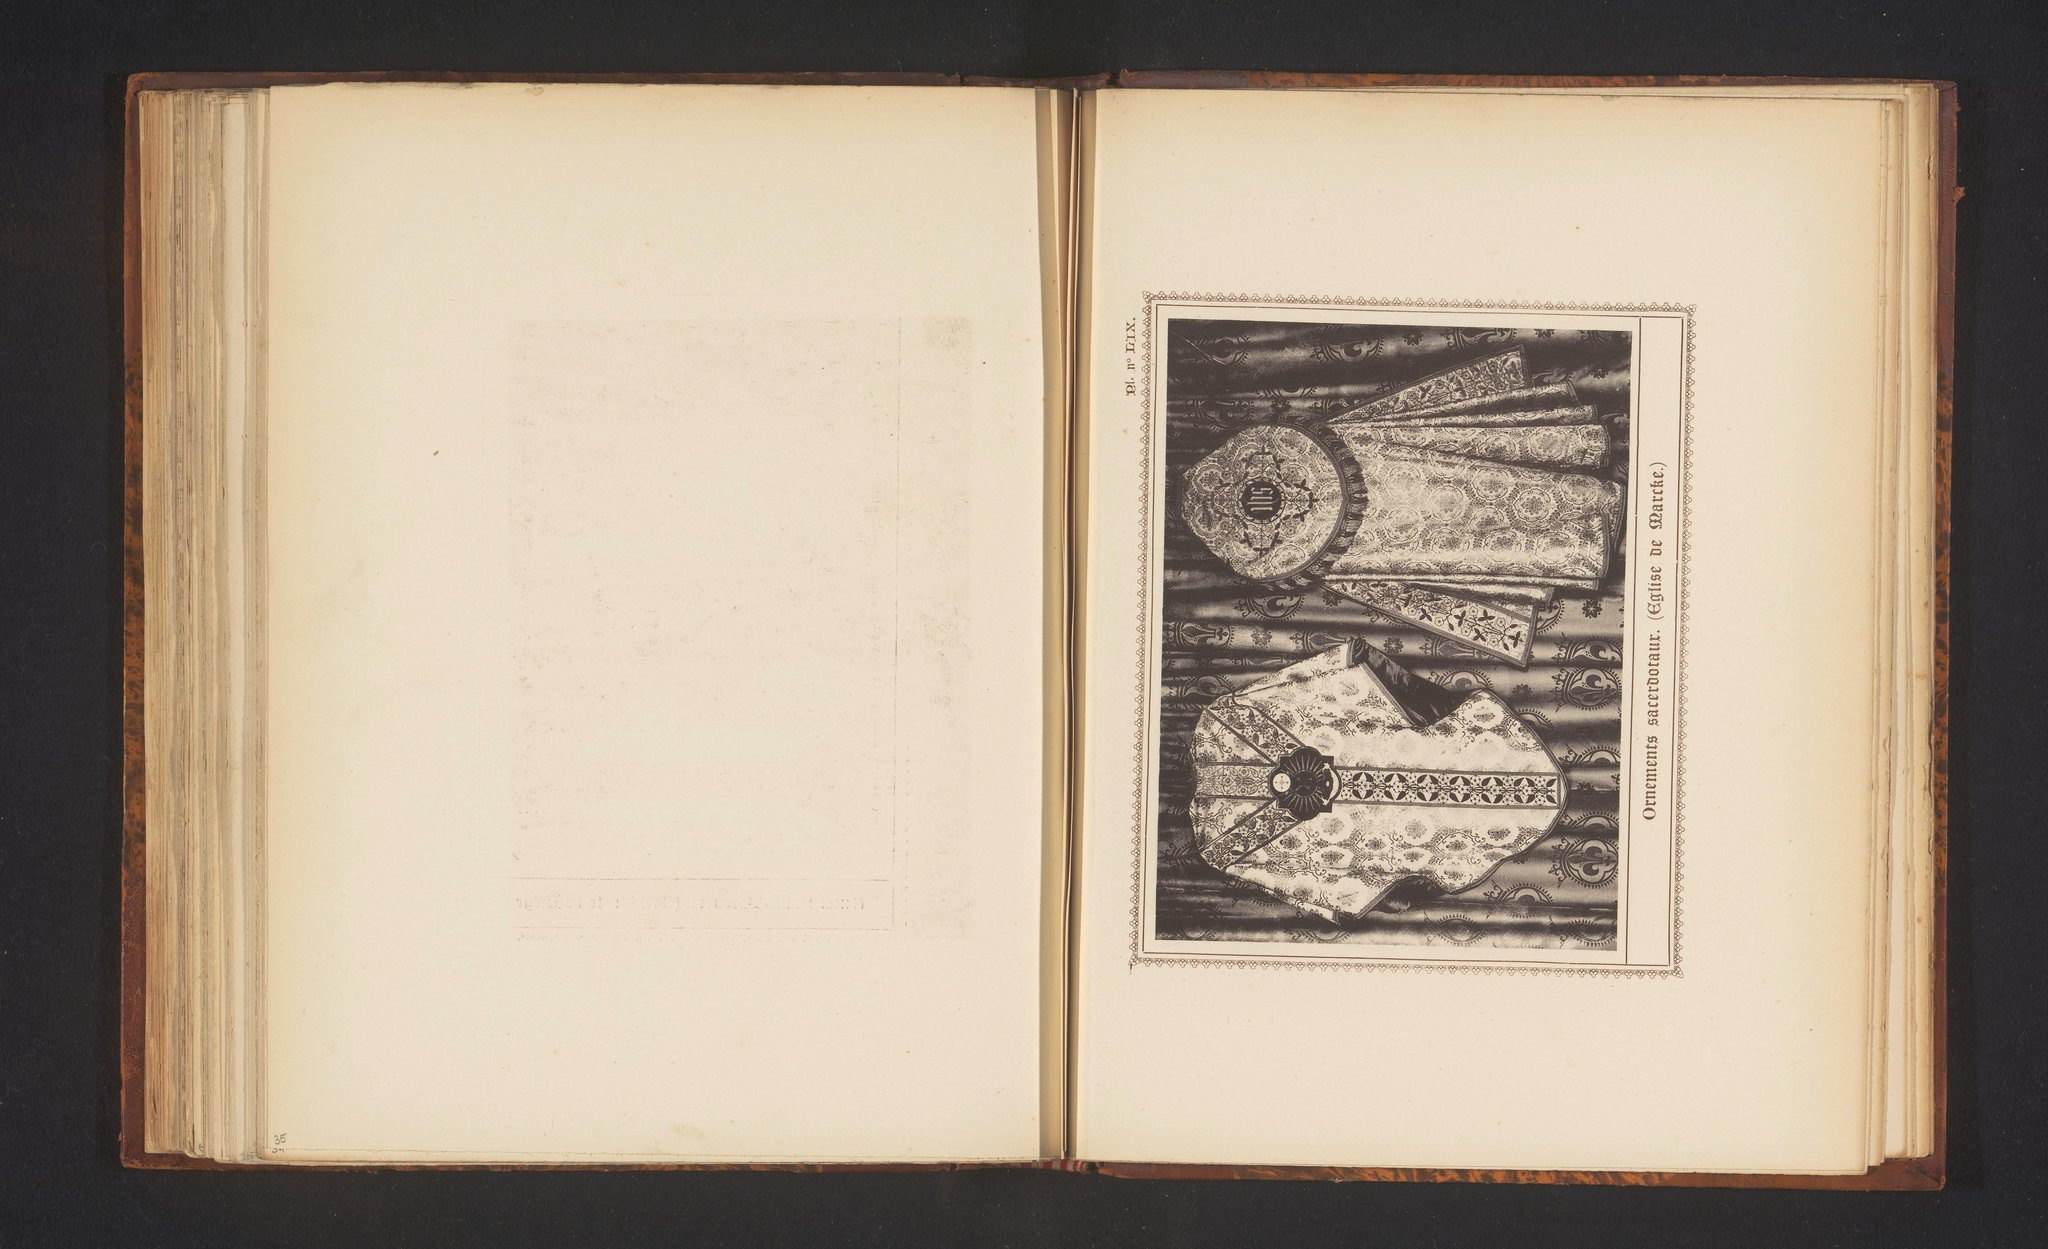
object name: page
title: Twee priesterlijke gewaden in de kerk van Marke in Kortrijk, België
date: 1891-1896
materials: paper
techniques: photograph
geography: kortrijk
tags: liturgical vestments, canonicals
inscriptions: number: ‘Pl. no LIX.’